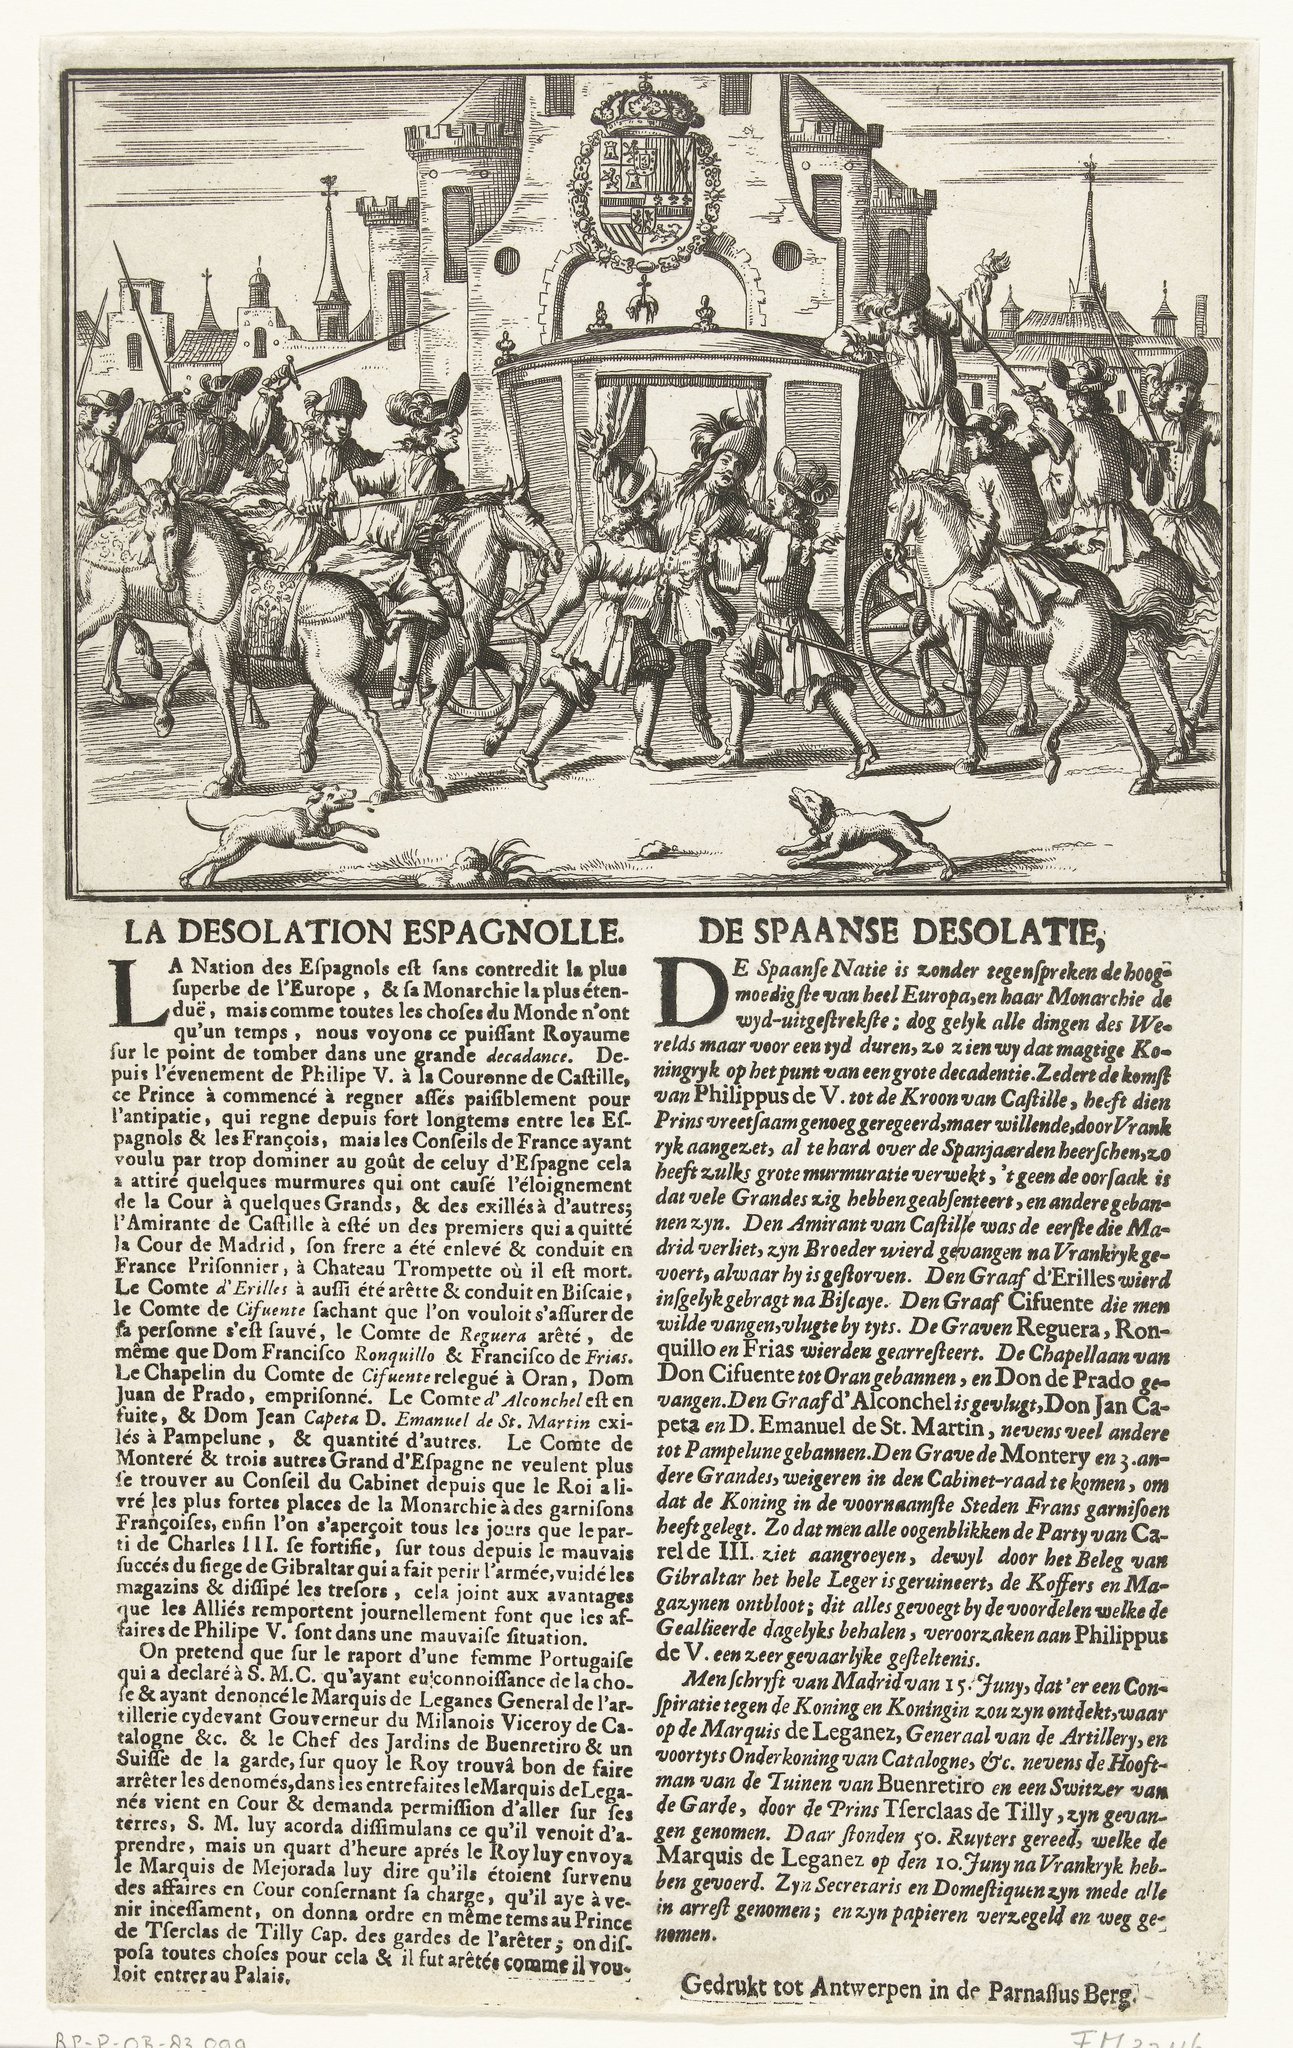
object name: print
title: La Desolation Espagnolle / De Spaanse Desolatie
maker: Anonymous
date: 1705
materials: paper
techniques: etching, letterpress printing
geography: northern netherlands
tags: arrest (of criminal)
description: Gevangenneming van de markies van Leganez te Madrid op 15 juni 1705. Onderdeel van de onderdrukking op last van Filips V van een vermoede samenzwering van Spaanse edelen. Op het blad onder de plaat teksten in het Frans en Nederlands. Onderdeel van een groep afzonderlijke spotprenten op Lodewijk XIV tijdens de Spaanse Successieoorlog, ca. 1701-1713.